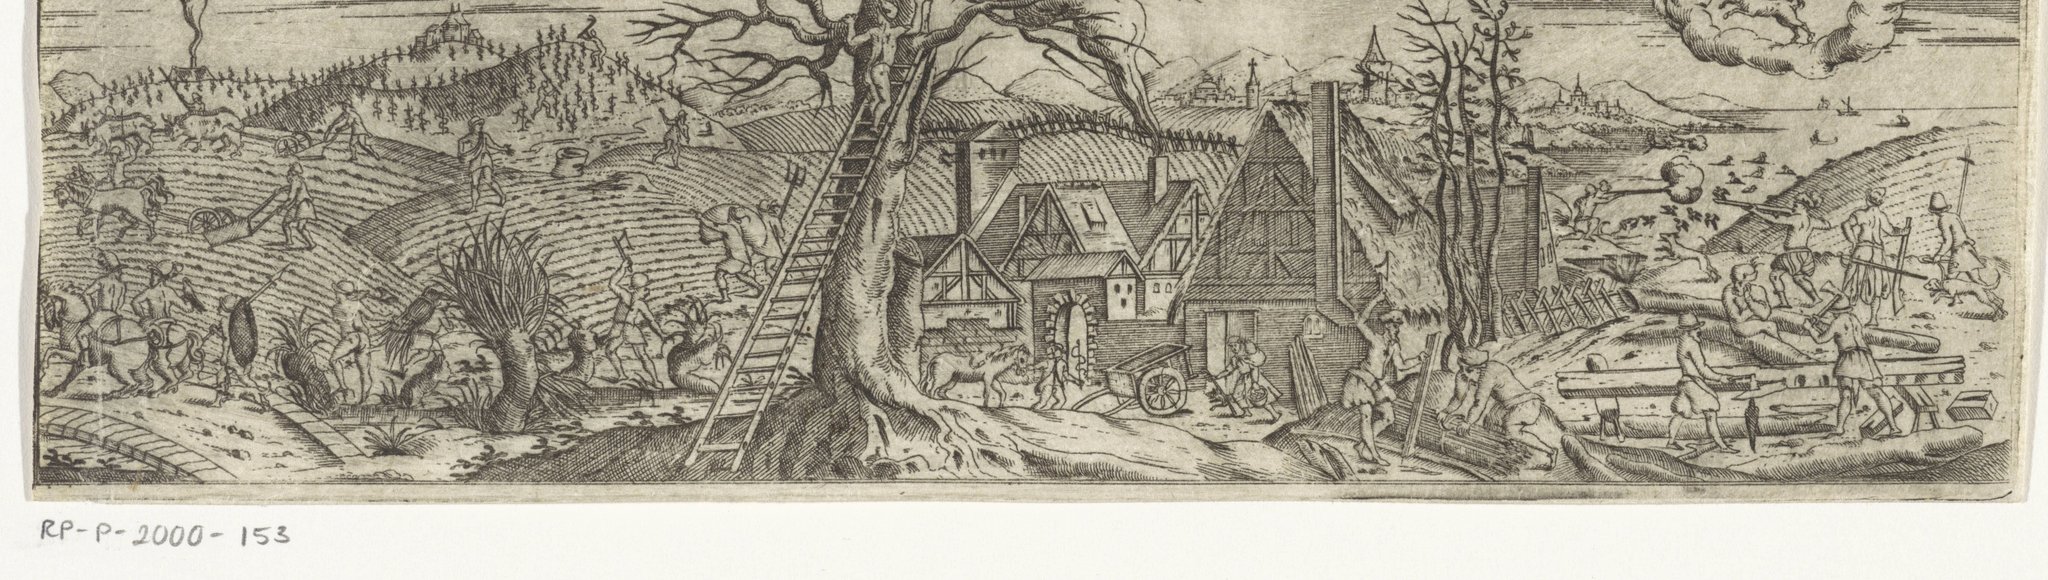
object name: print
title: December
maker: Anonymous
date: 1554-1641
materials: paper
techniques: etching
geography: netherlands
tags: december and its 'labours' (+ with zodiacal signs)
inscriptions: collector's mark: Lugt 2760, collector's mark: Lugt 2228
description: De bezigheden in de maand december. Links wordt het land bewerkt en worden bomen gesnoeid. Rechts hakken enkele mannen hout en vindt een jachtpartij plaats. Rechts in de lucht het dierenriemteken Steenbok.